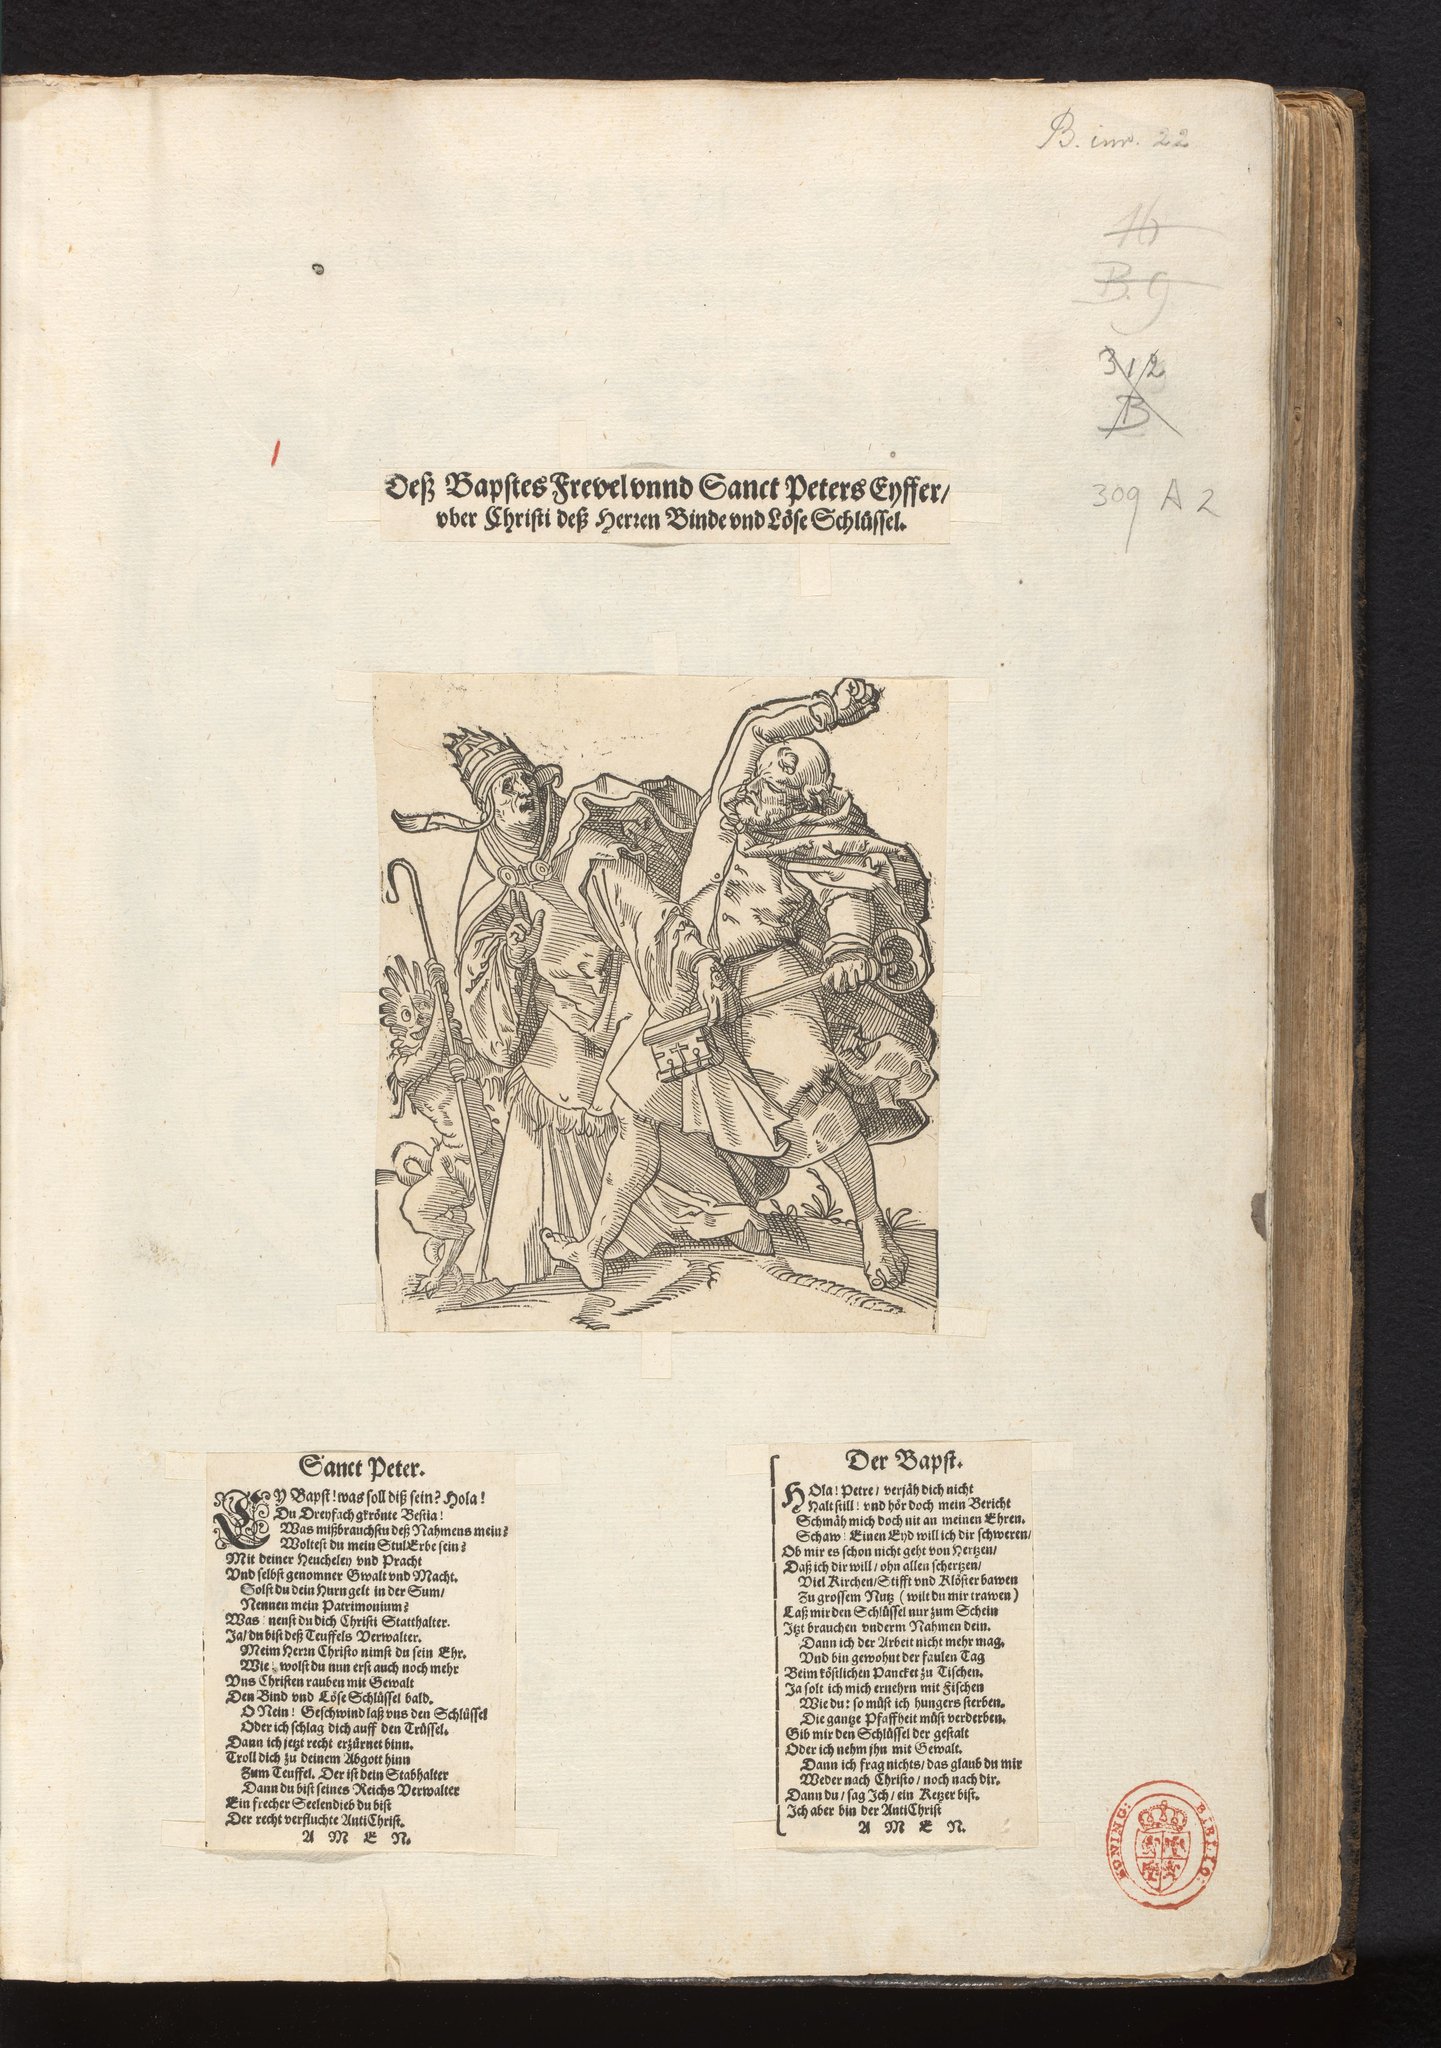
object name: pamphlet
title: Malcho Papo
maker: Anonymous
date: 1549-1577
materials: paper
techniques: letterpress printing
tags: pope - pp - antipope, the apostle peter, first bishop of rome; possible attributes: book, cock, (upturned) cross, (triple) crozier, fish, key, scroll, ship, tiara, allegories and personifications ~ protestantism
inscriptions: collector's mark: Lugt 240, collector's mark: Lugt 2166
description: Prent gebruikt op het vlugschrift: Fischart, Johann. Malcho Papo. Straatsburg: Bernhard Jobin, 1577. De voorstelling is krap afgesneden. Delen van de tekst van de originele uitgave zijn ook op het albumblad geplakt.